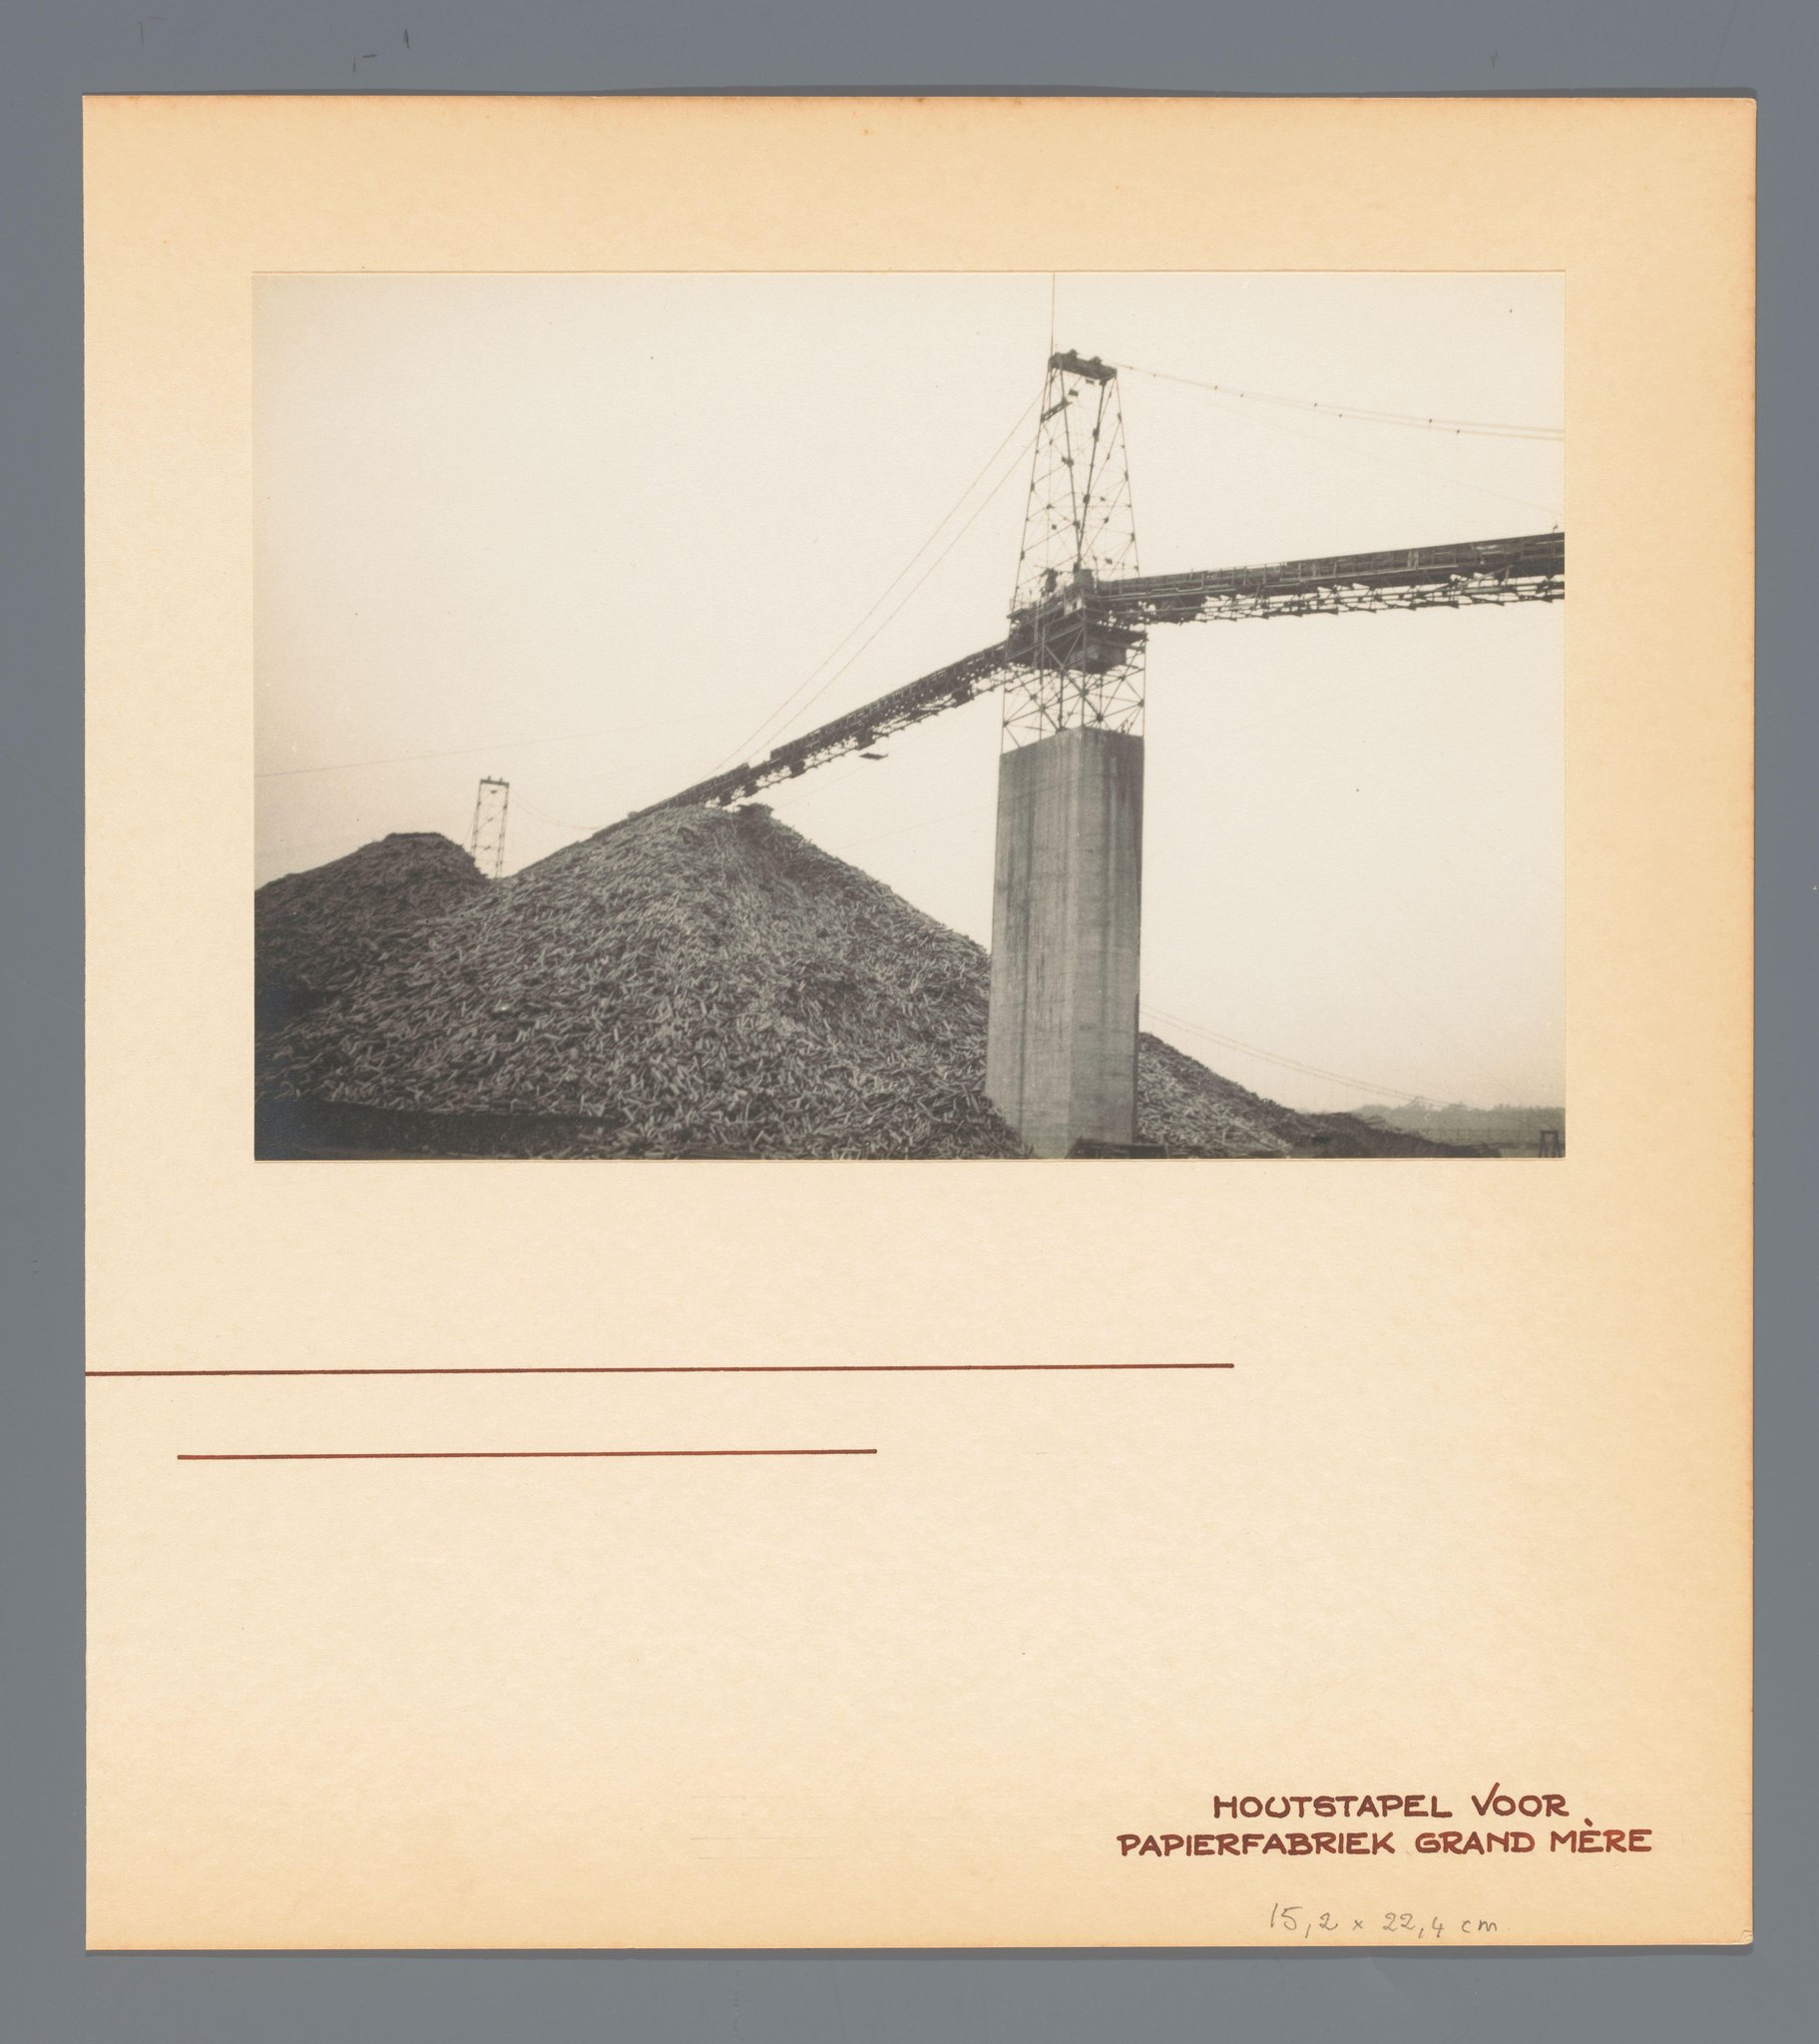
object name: photograph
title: Houtstapel bij papierfabriek in Grand Mère, bij Montréal, Canada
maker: wouter cool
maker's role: engineer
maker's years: 1877-1947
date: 1936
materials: cardboard, paper, photographic support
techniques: gelatin silver print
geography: united states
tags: industrial structures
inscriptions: title: ‘HOUTSTAPEL VOOR / PAPIERFABRIEK GRAND MERE’